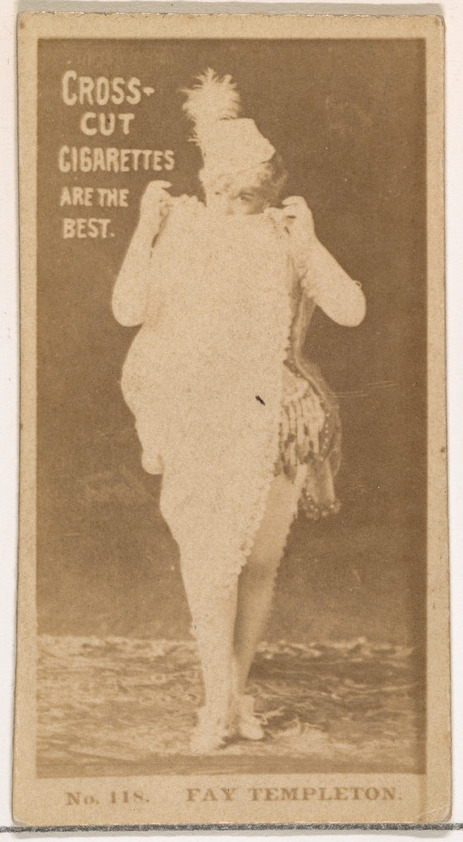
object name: print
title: Card Number 118, Fay Templeton, from the Actors and Actresses series (N145-2) issued by Duke Sons & Co. to promote Cross Cut Cigarettes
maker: w. duke, sons & co.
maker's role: publisher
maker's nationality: american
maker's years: 1870-1920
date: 1880-1889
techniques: albumen silver print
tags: portraits,women,actresses